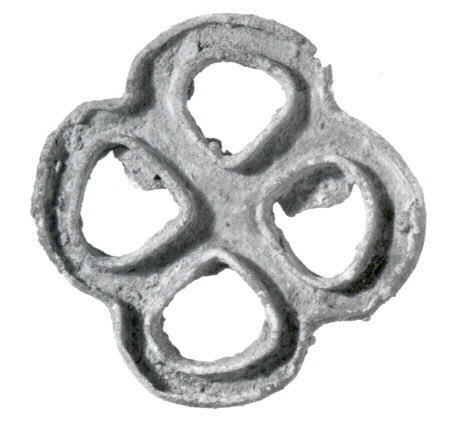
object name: stamp seal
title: Compartmented stamp seal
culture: bactria-margiana archaeological complex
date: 2333-1668 BCE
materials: copper alloy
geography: bactria-margiana